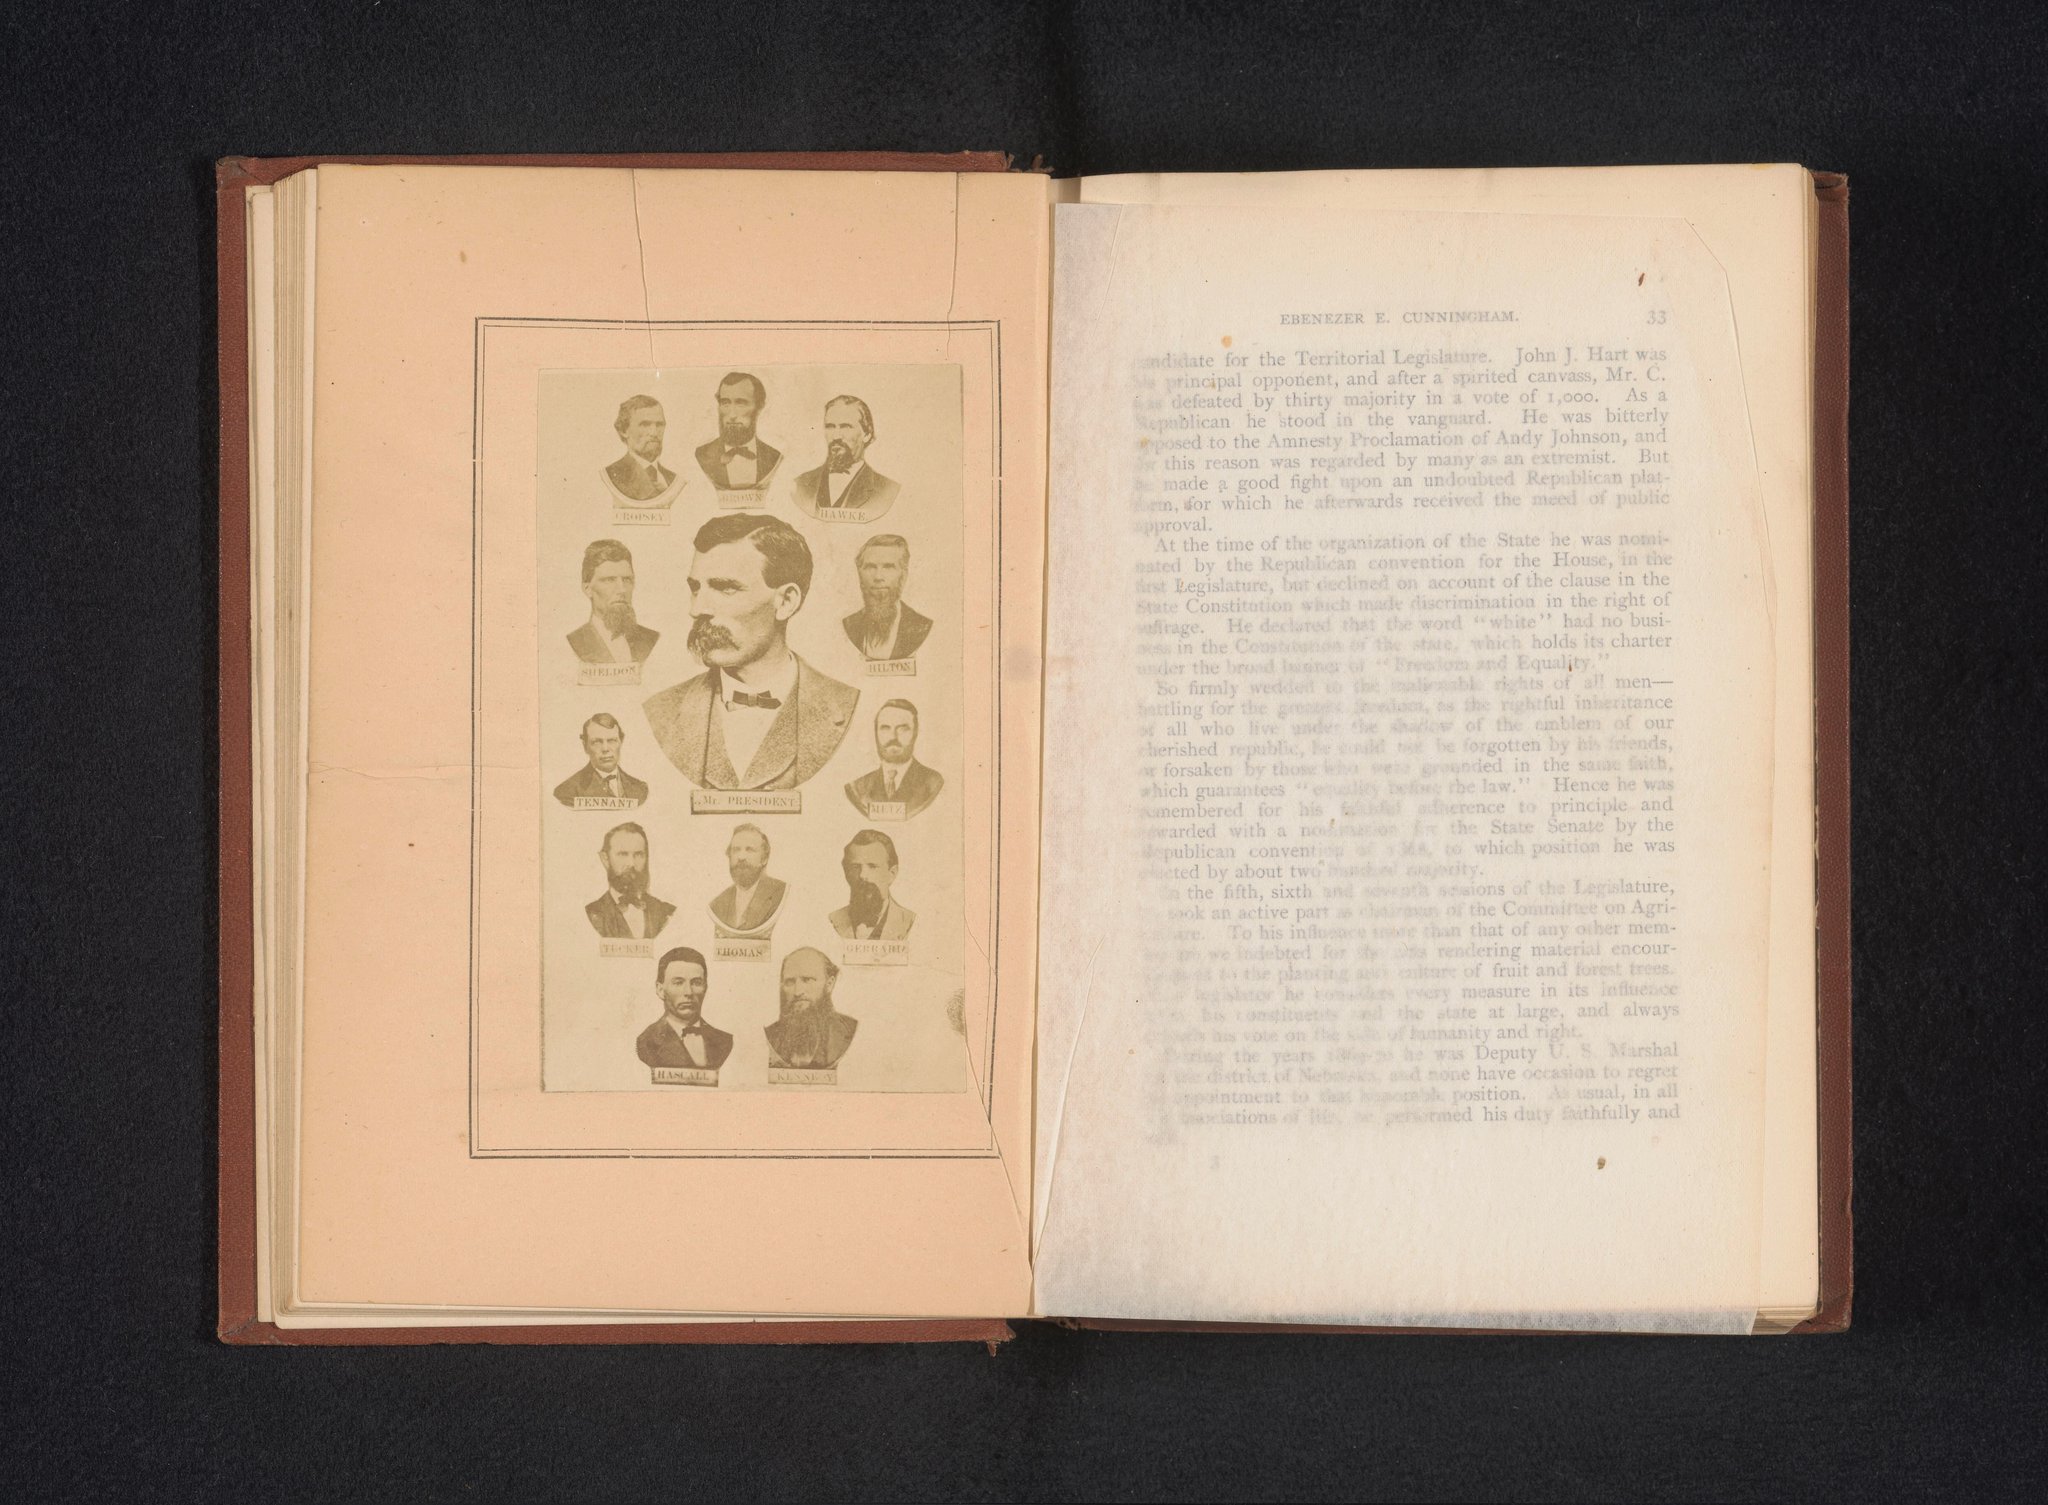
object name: page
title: Fotomontage van 13 Amerikaanse senatoren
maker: edric l. eaton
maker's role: fotograaf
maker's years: 1835-1890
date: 1866-1871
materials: photographic support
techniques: albumen print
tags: new york, historical persons, politician, e.g. party leader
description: Foto tegenover pagina 33, zie index voor overige namen.